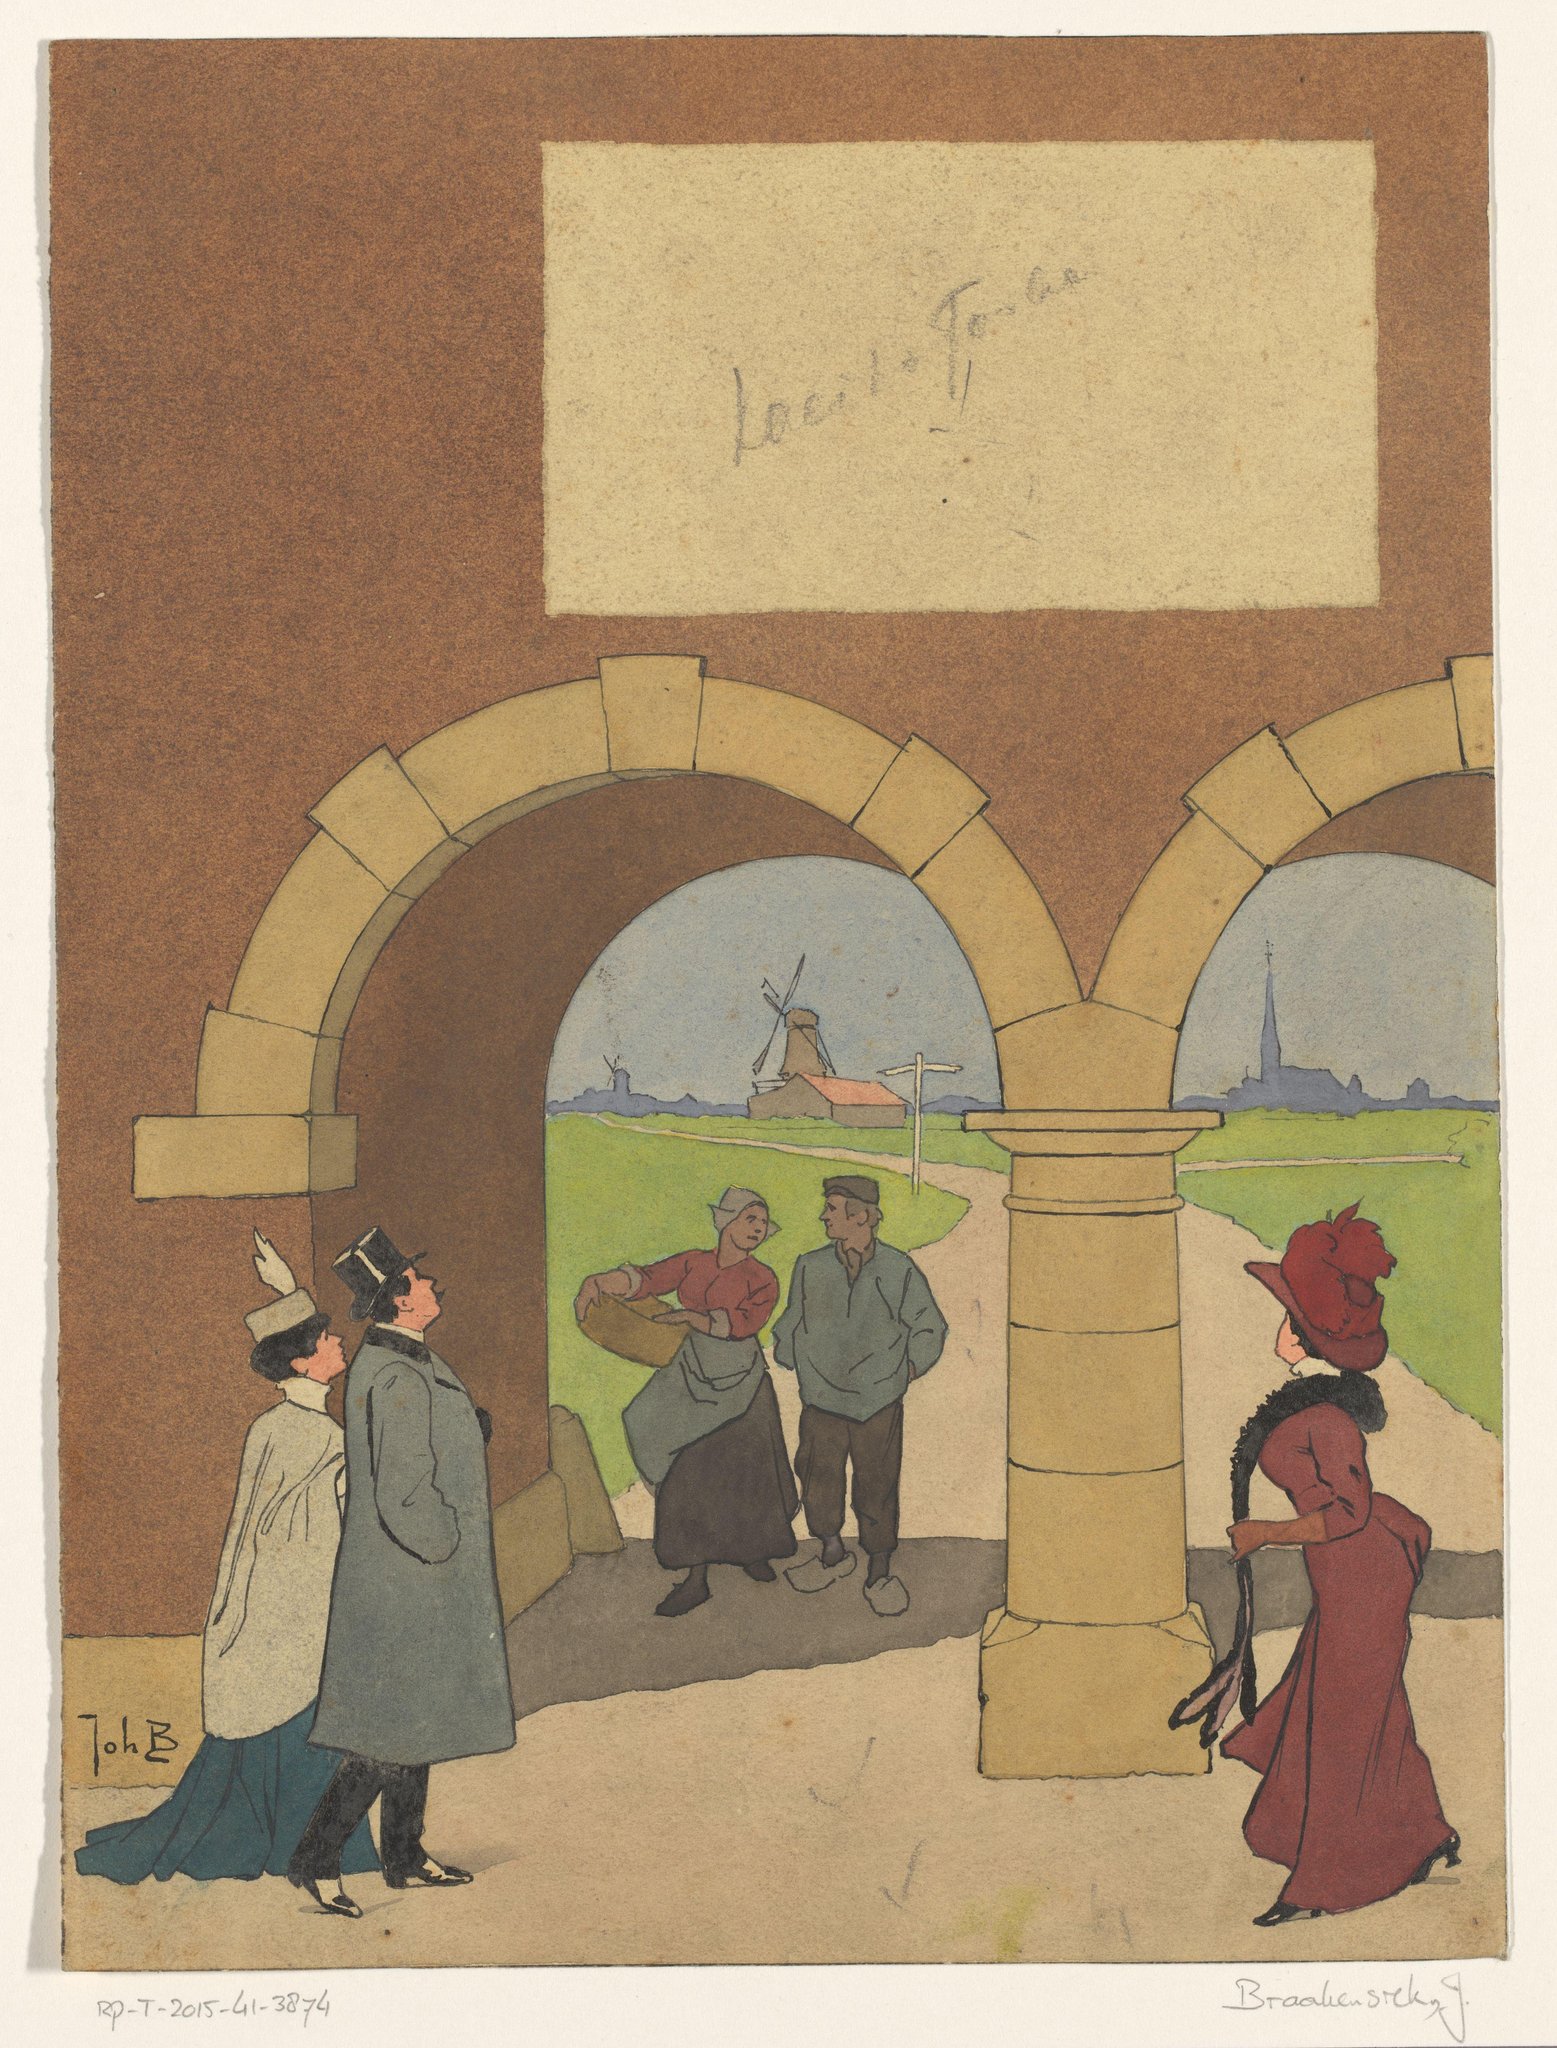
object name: study for binding design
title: Bandontwerp met wandelaars bij een poortgebouw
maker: johan braakensiek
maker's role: draughtsman, print maker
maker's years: 1858-1940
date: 1868-1940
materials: ink, paper, pencil, watercolor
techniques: brush, pen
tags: city-view, and landscape with man-made constructions, gate, entrance, walking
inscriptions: annotation: ‘La[...]ito[...]ka’, collector's mark: Lugt 2228a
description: Rondom een poortgebouw wandelen verschillende mensen, waaronder een echtpaar en een boer en boerin. In de achtergrond weilanden met molens, boerderijen en een kerktoren.